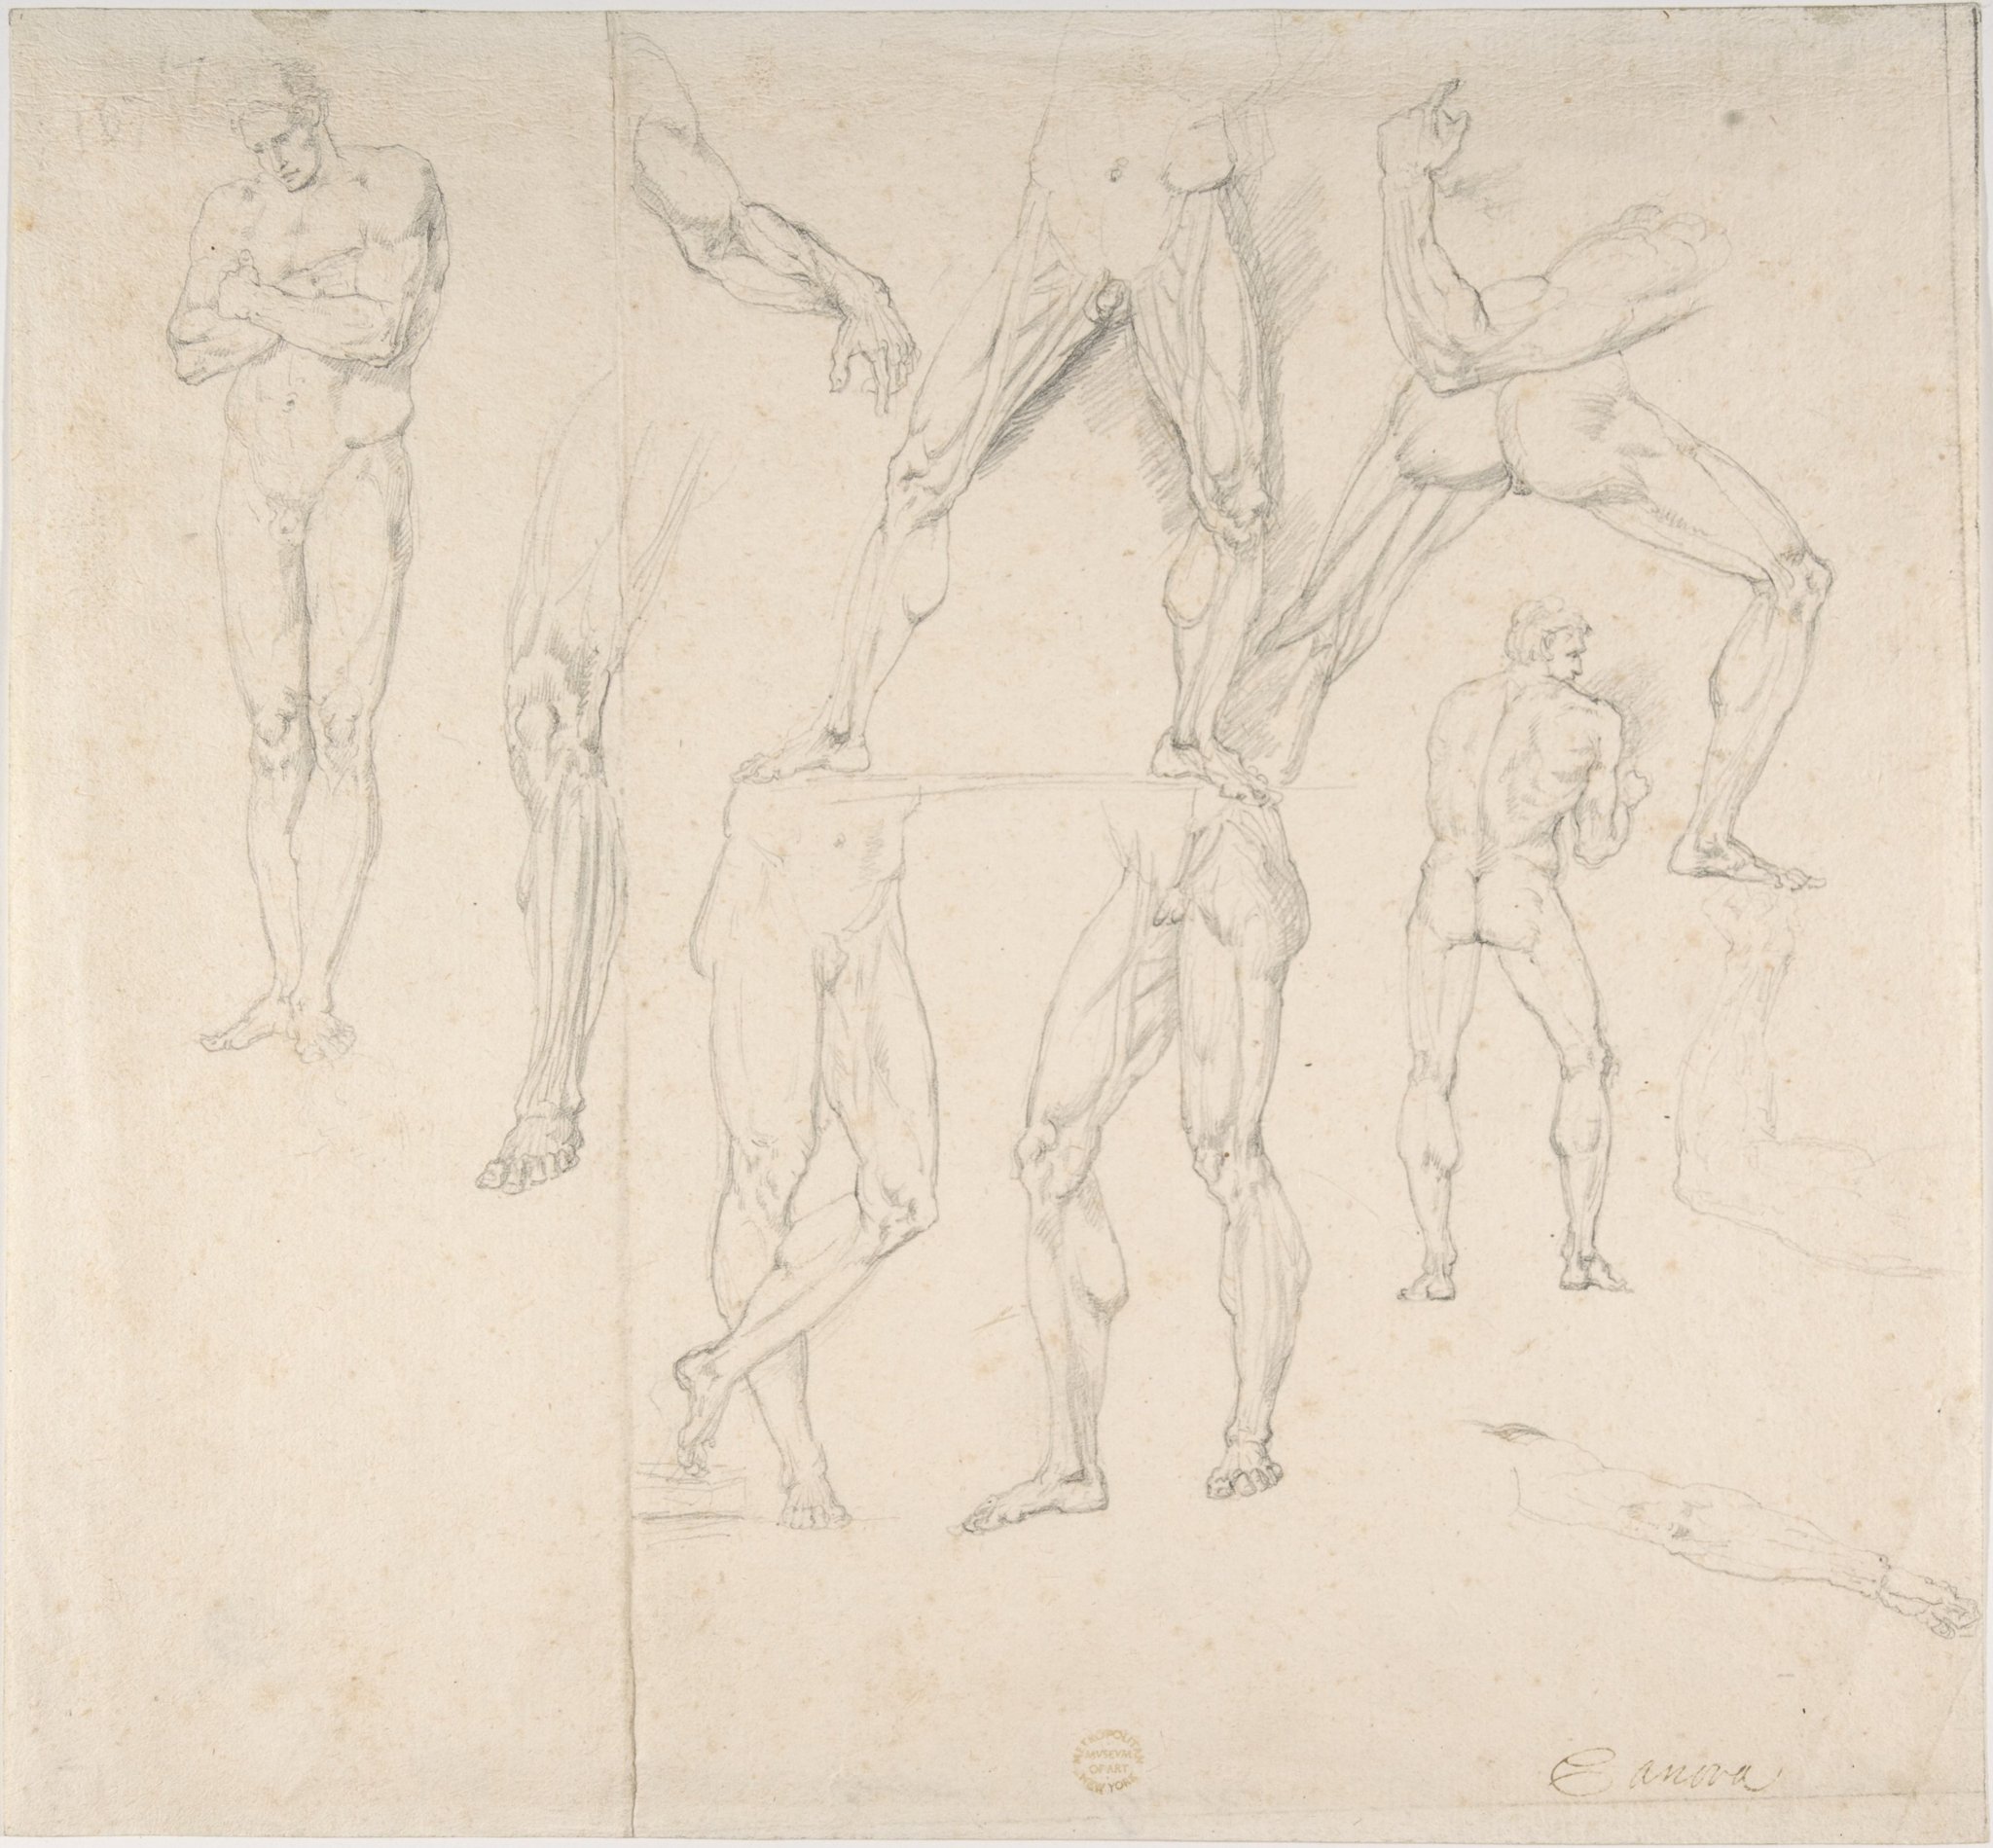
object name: drawing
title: Nude Study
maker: anonymous, italian, early 19th century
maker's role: artist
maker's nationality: italian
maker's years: 1800-1825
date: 1801-1833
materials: ink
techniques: pen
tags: hands,male nudes